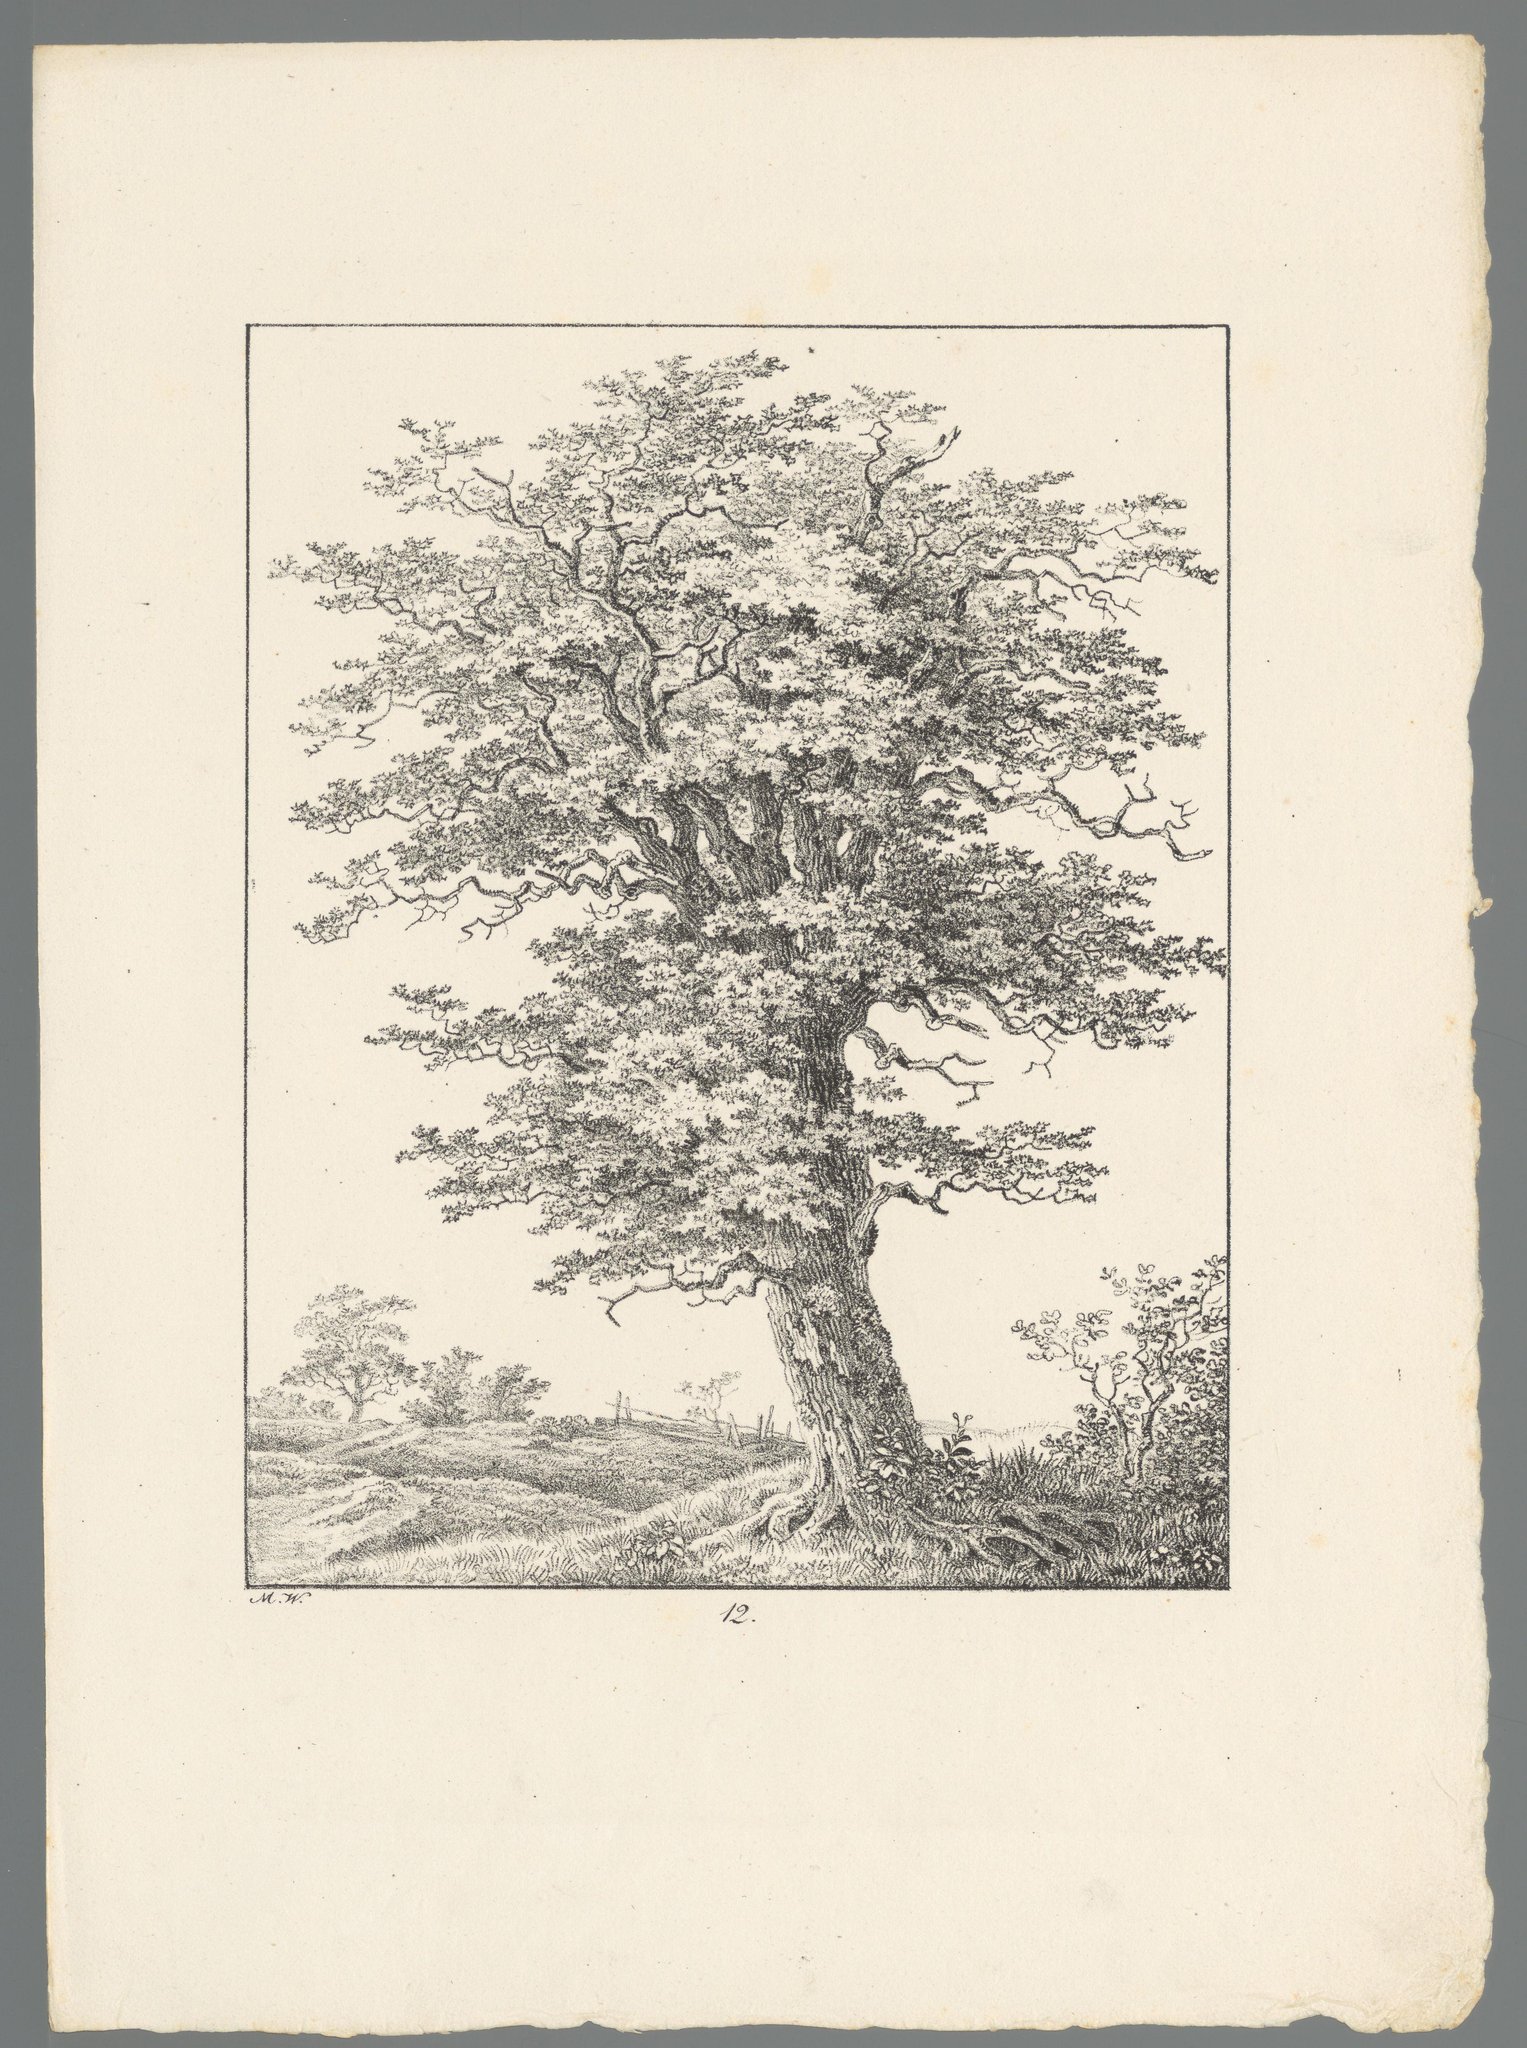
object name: print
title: Voorbeelden voor landschapstekenaars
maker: max josef wagenbauer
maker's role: print maker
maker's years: 1774-1829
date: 1823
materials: paper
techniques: lithograph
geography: munich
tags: trees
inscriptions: collector's mark: Lugt 2228, collector's mark: Lugt 2760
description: Prent behoort tot het eerste deel van de serie 'Vorlagen für Landschaft-zeichner'. Dit eerste deel bevat twintig prenten.